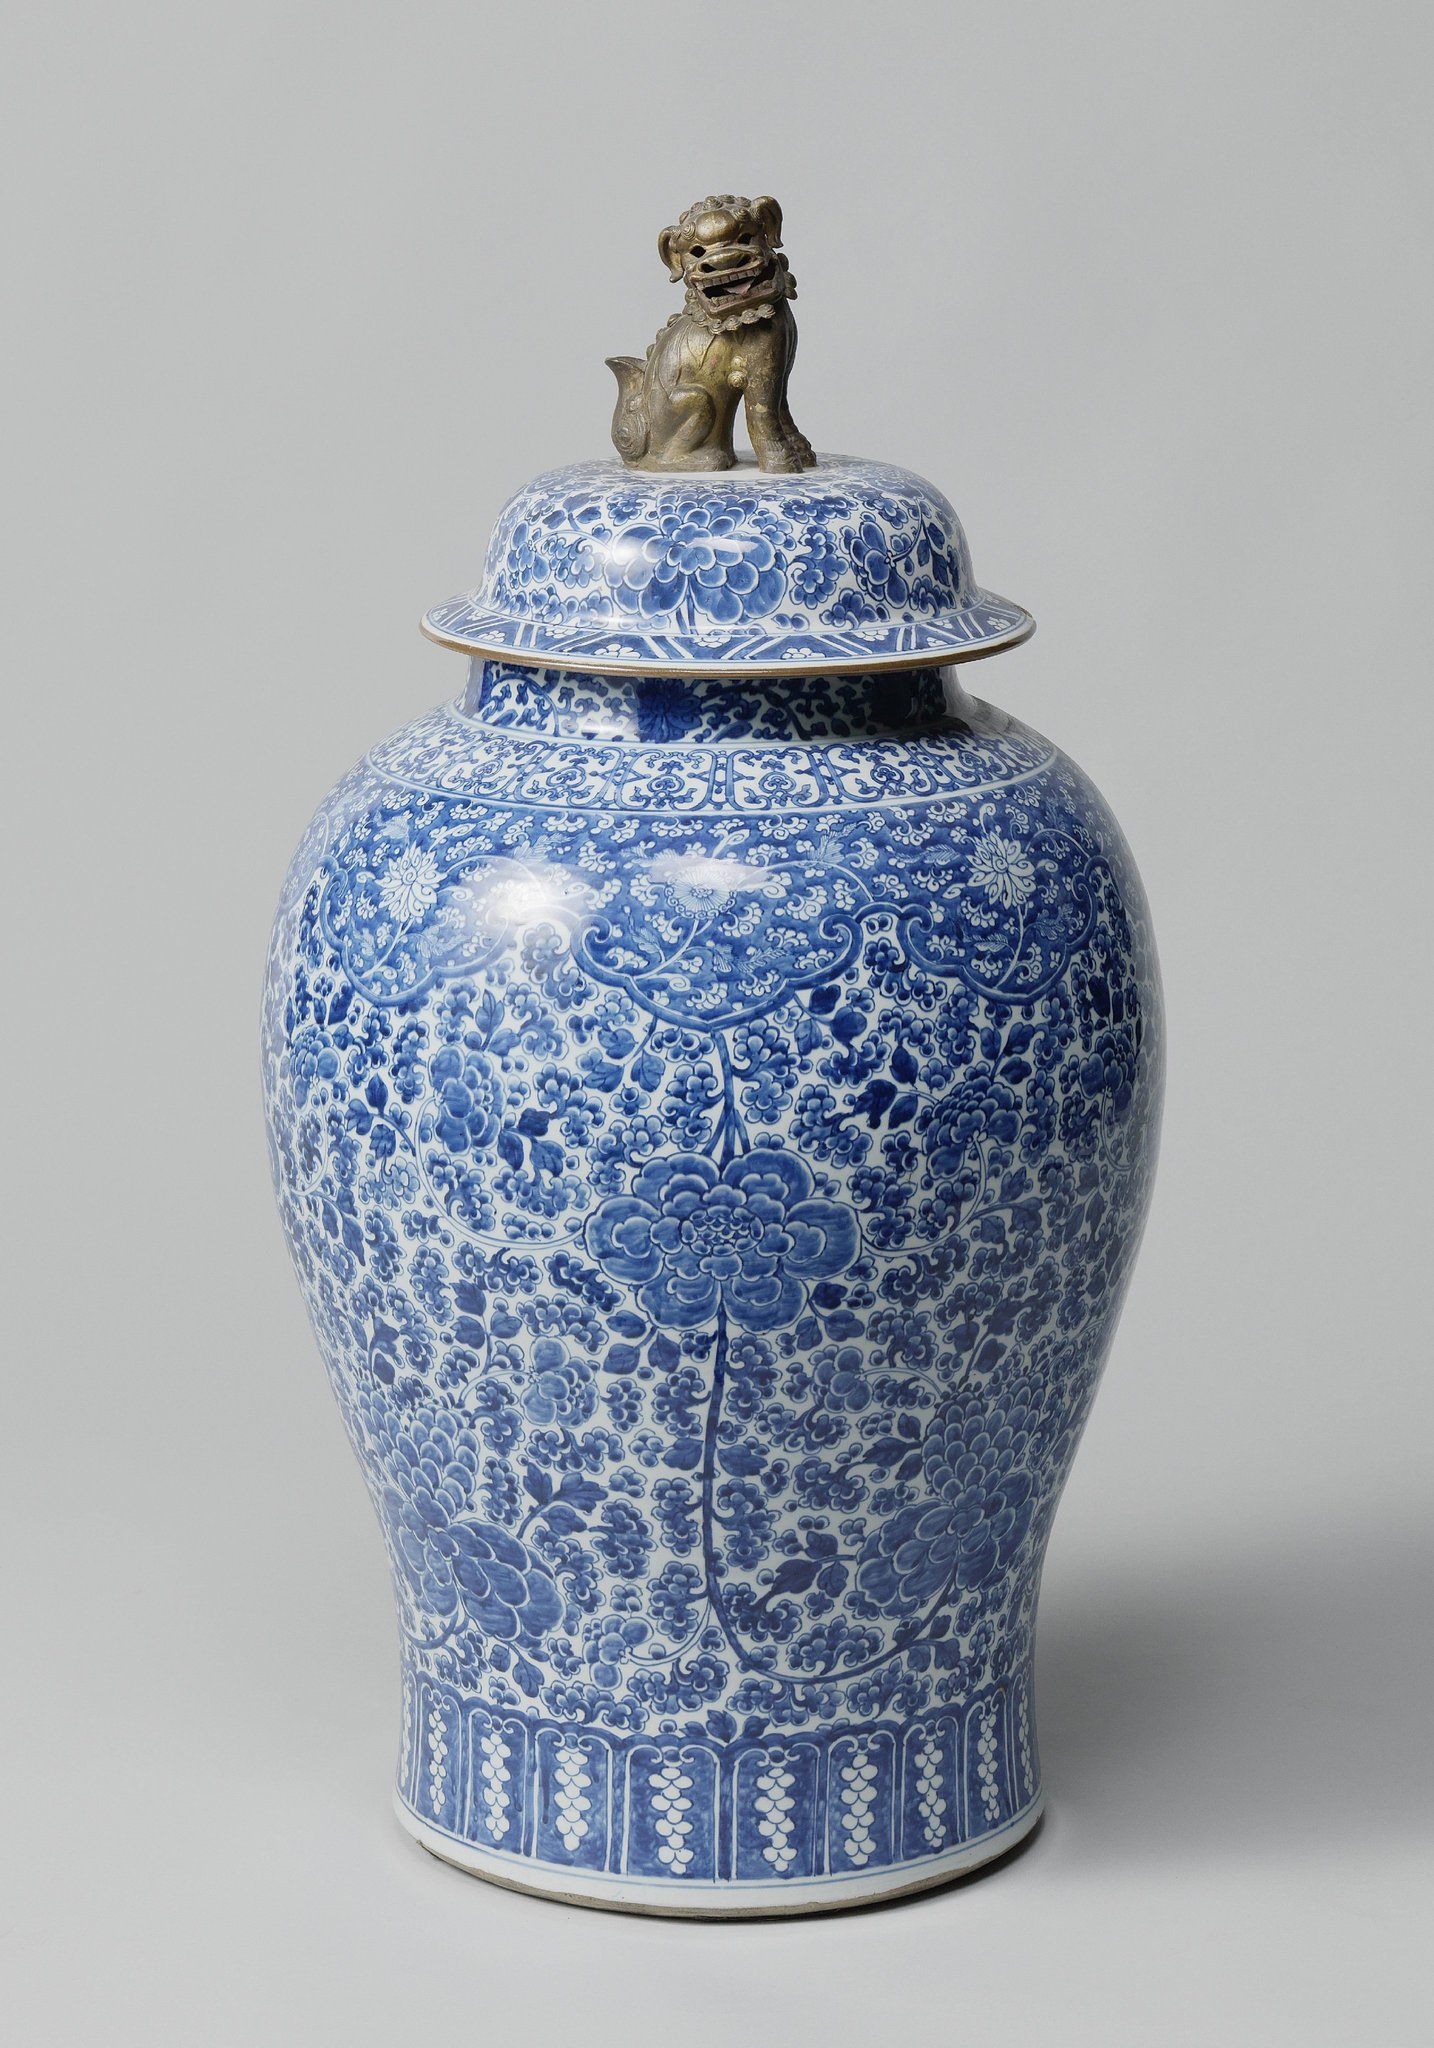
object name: dekselvaas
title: Lidded Vase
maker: Anonymous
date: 1700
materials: bronze, cobalt, glaze, gold, paint, porcelain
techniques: firing, forming, gilding, turning, vitrification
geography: china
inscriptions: mark: ‘N393’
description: There were many porcelain connoisseurs in Europe during the 17th and 18th centuries. Monarchs as well as wealthy individuals assembled huge collections. August the Strong, Elector of Saxony and King of Poland, was the greatest collector. He filled entire palaces with porcelain. He had the pieces marked on their bases with incised numbers and symbols. These two large vases came from his collection.